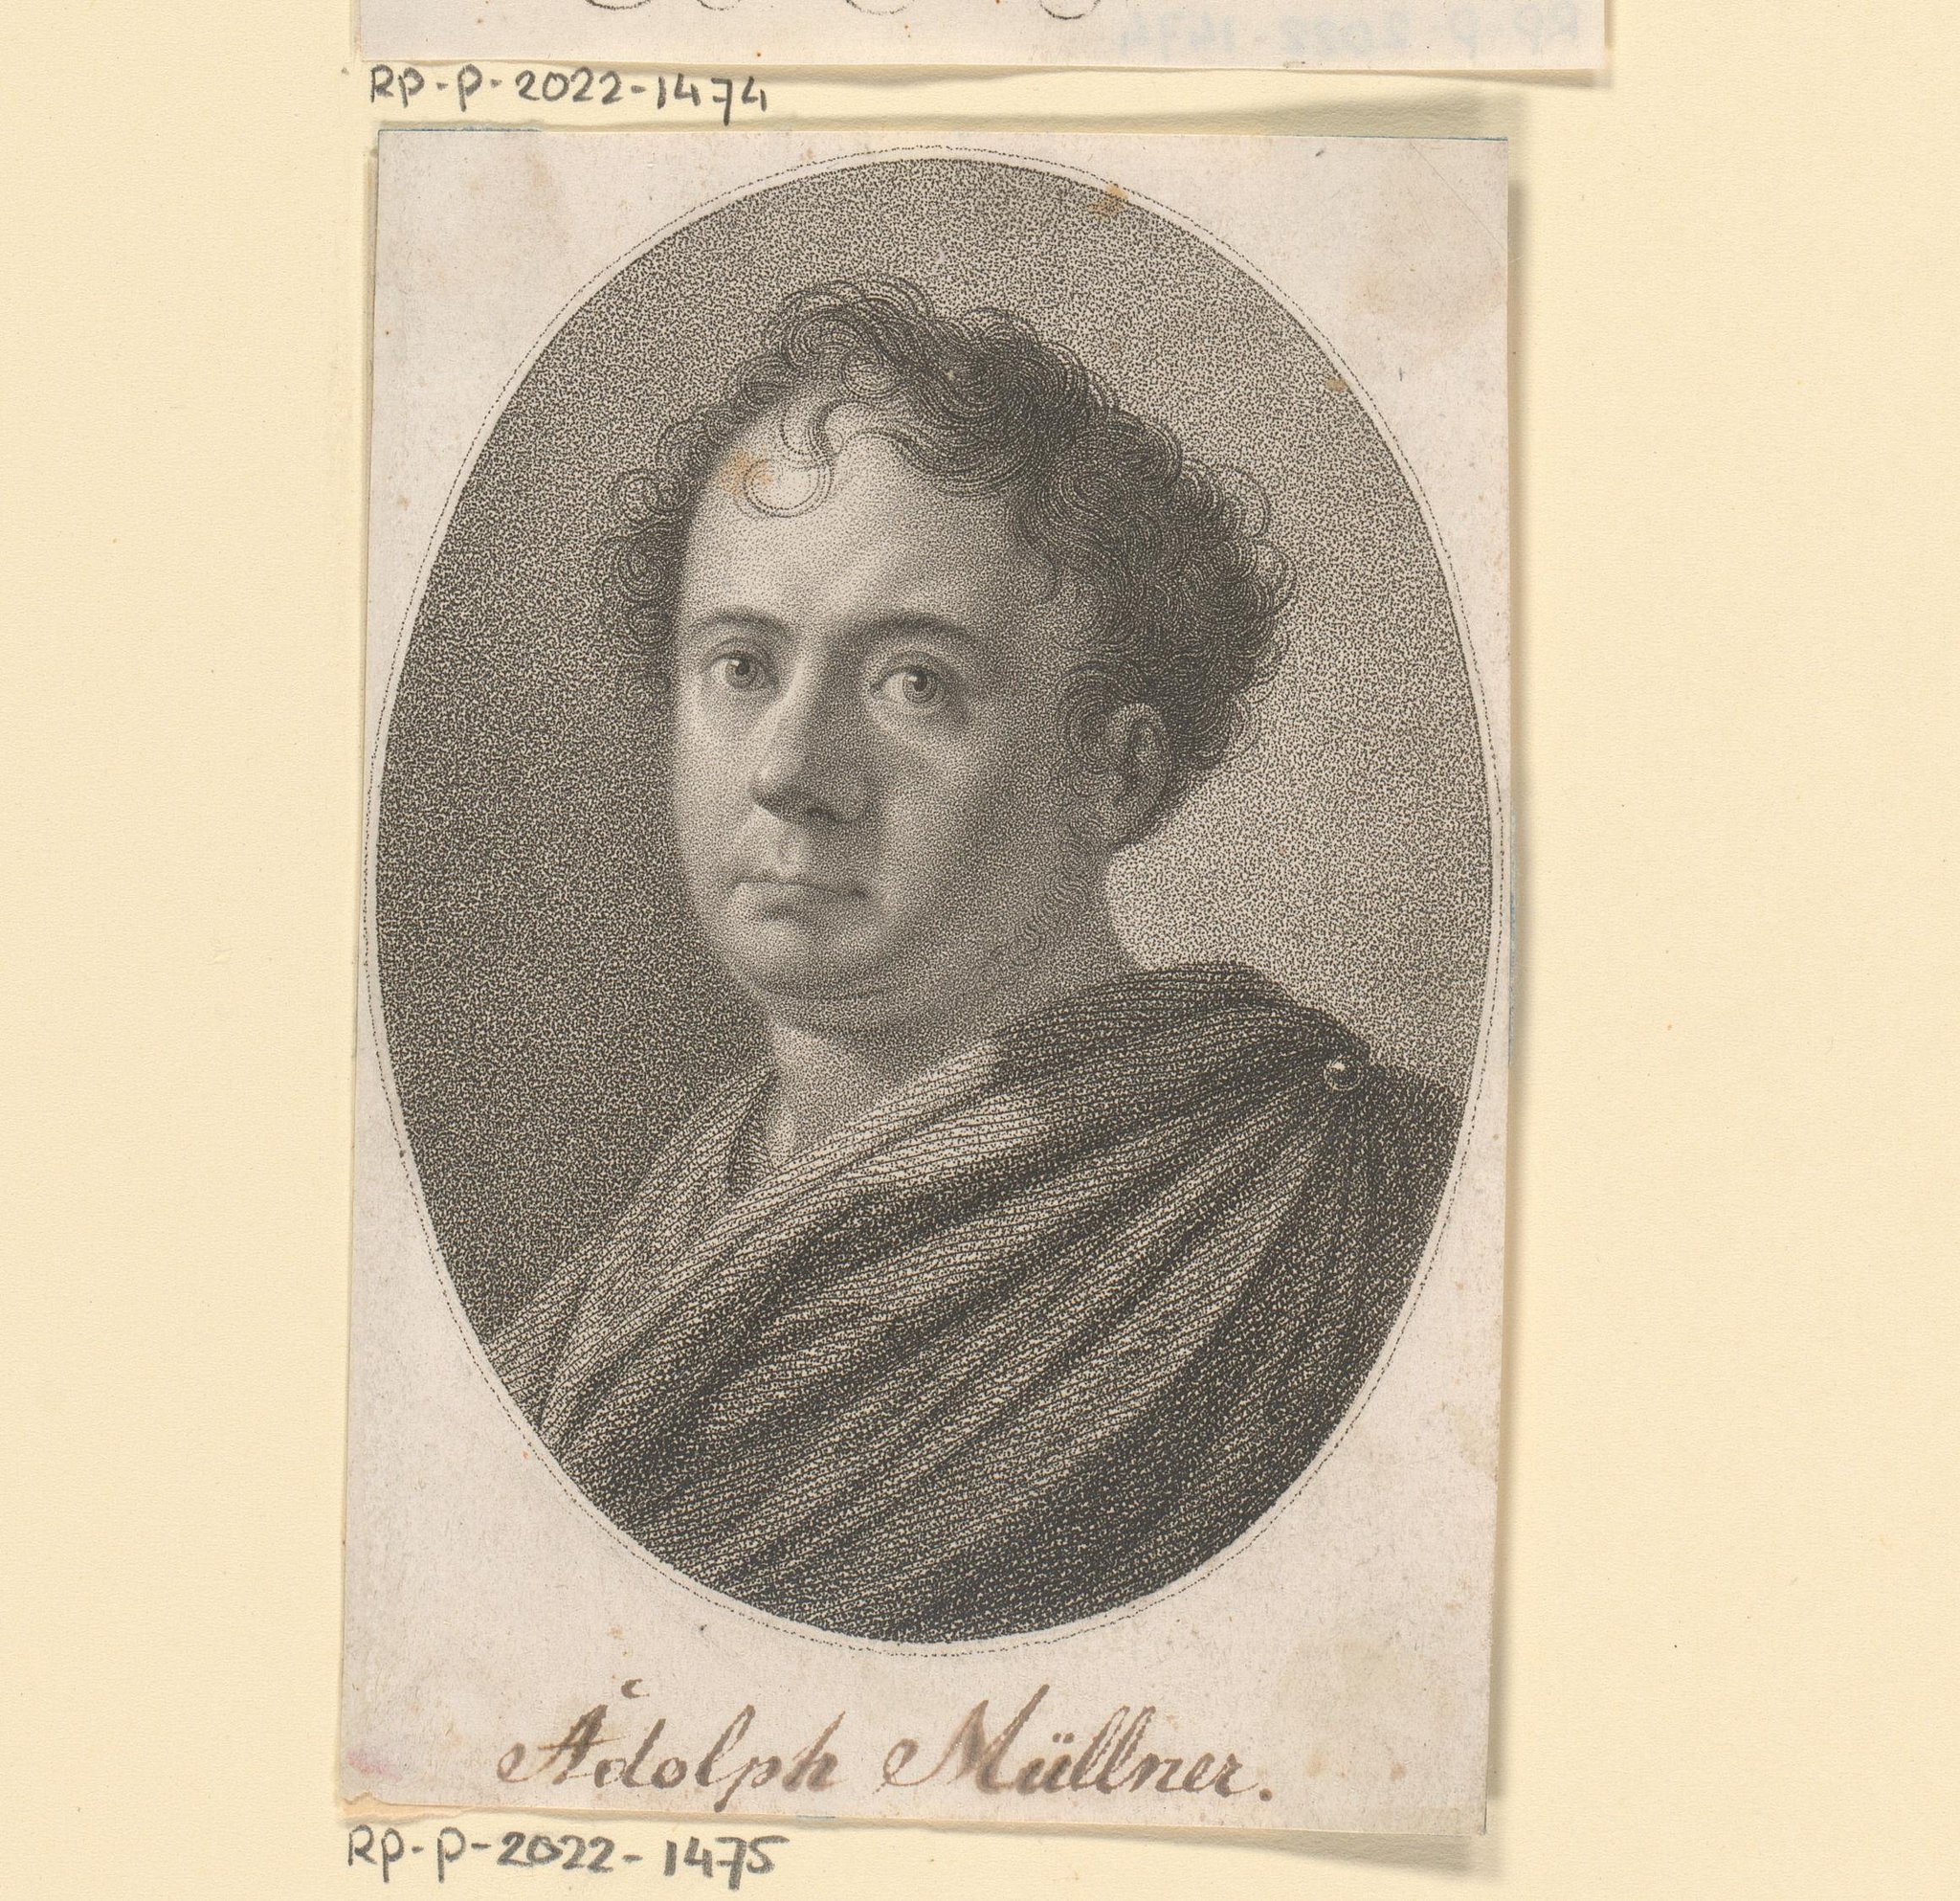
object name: print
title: Portret van Adolph Müllner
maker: Anonymous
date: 1800-1900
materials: paper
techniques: engraving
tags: historical persons, lawyer, attorney at law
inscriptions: inscription: ‘Adolph Müllner’